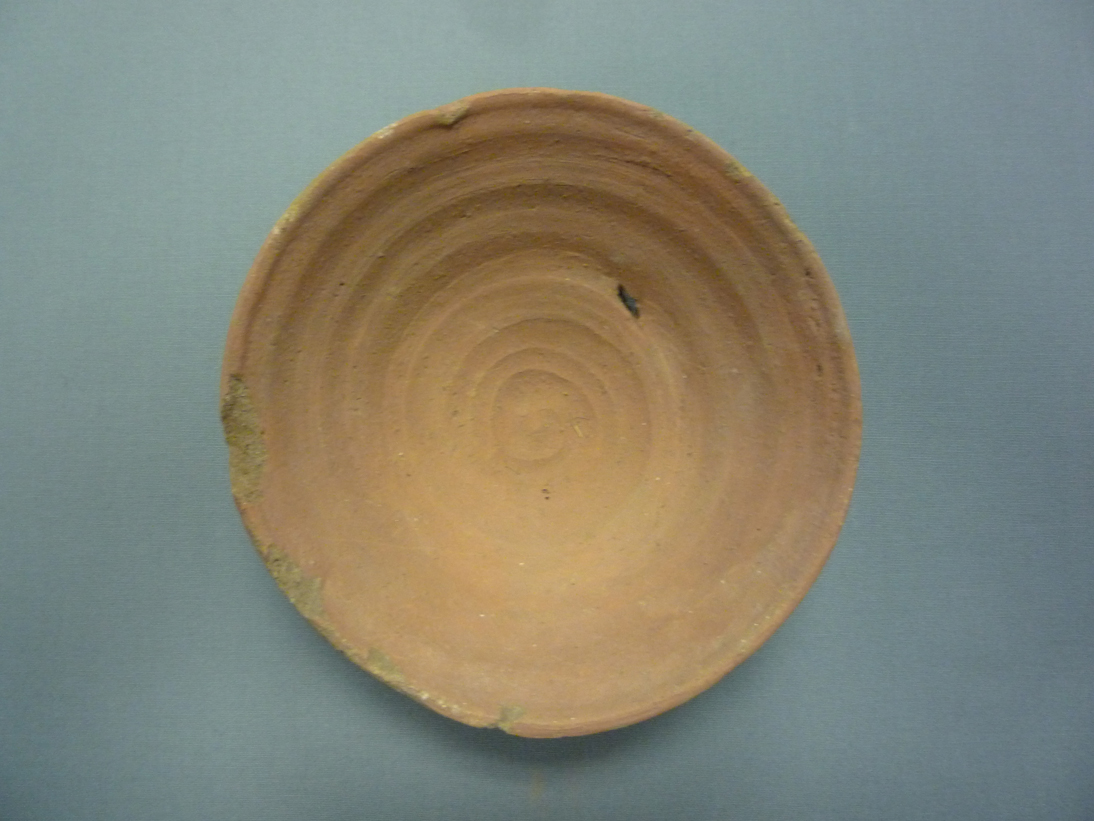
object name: bowl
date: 1479-1458 BCE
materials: pottery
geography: egypt